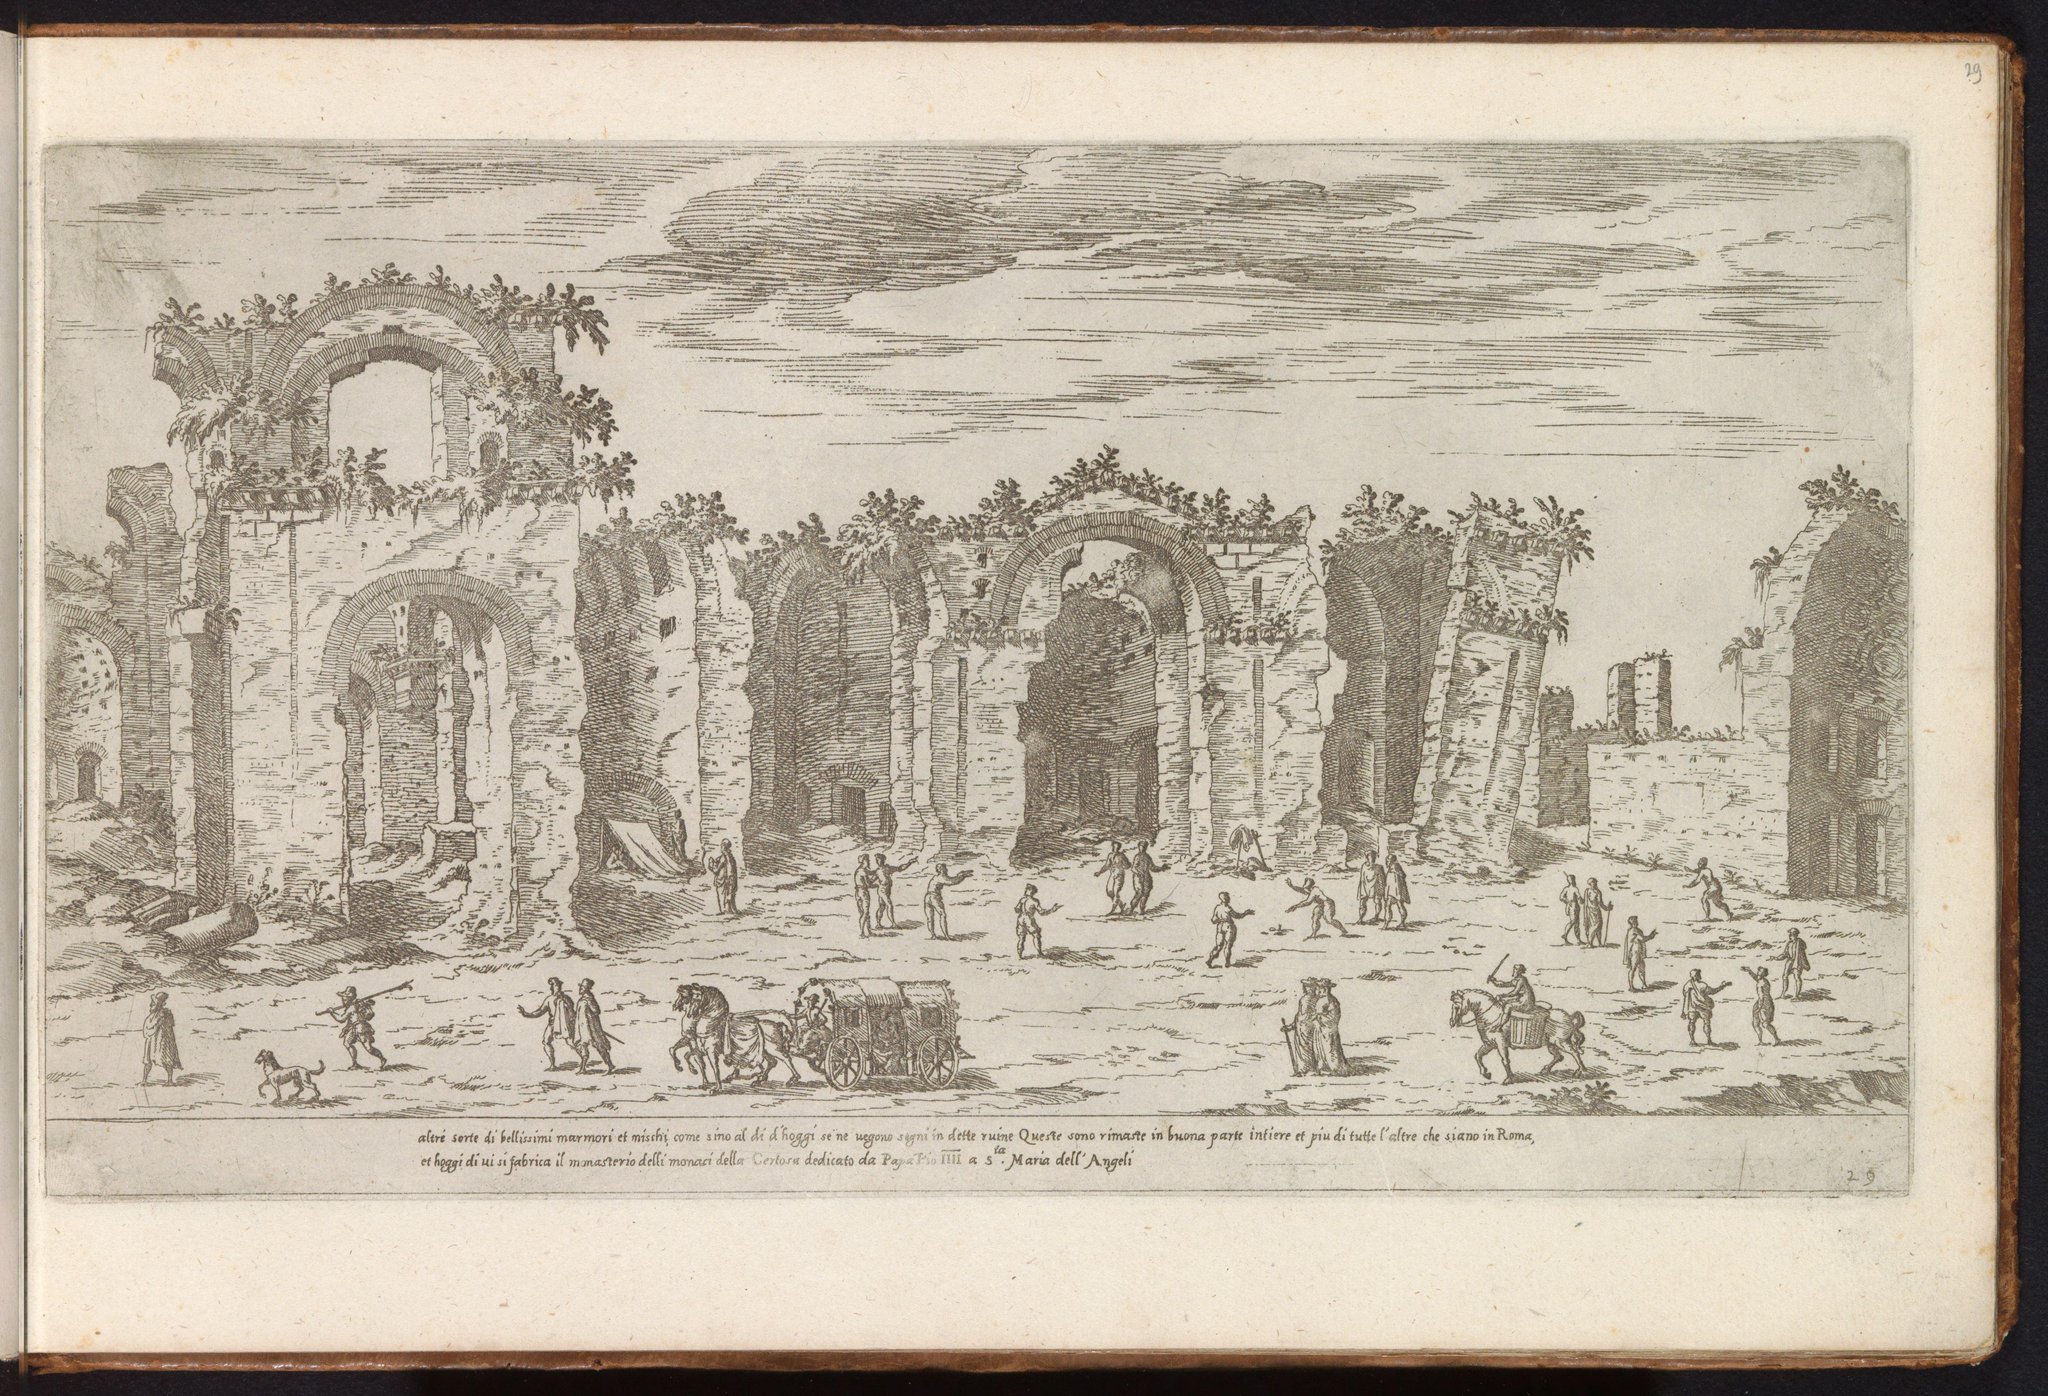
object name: print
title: I vestigi dell'antichità di Roma raccolti et ritratti in perspettiva da Stefano Du Perac Parisino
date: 1575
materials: paper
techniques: engraving, etching, intaglio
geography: italy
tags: city-view, and landscape with man-made constructions, ruin of a building ~ architecture, landscape with ruins, public baths - aa - in the open air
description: Gezicht op de resten van de Thermen van Diocletianus te Rome. Onderschrift in het Italiaans. Prent maakt deel uit van een album.